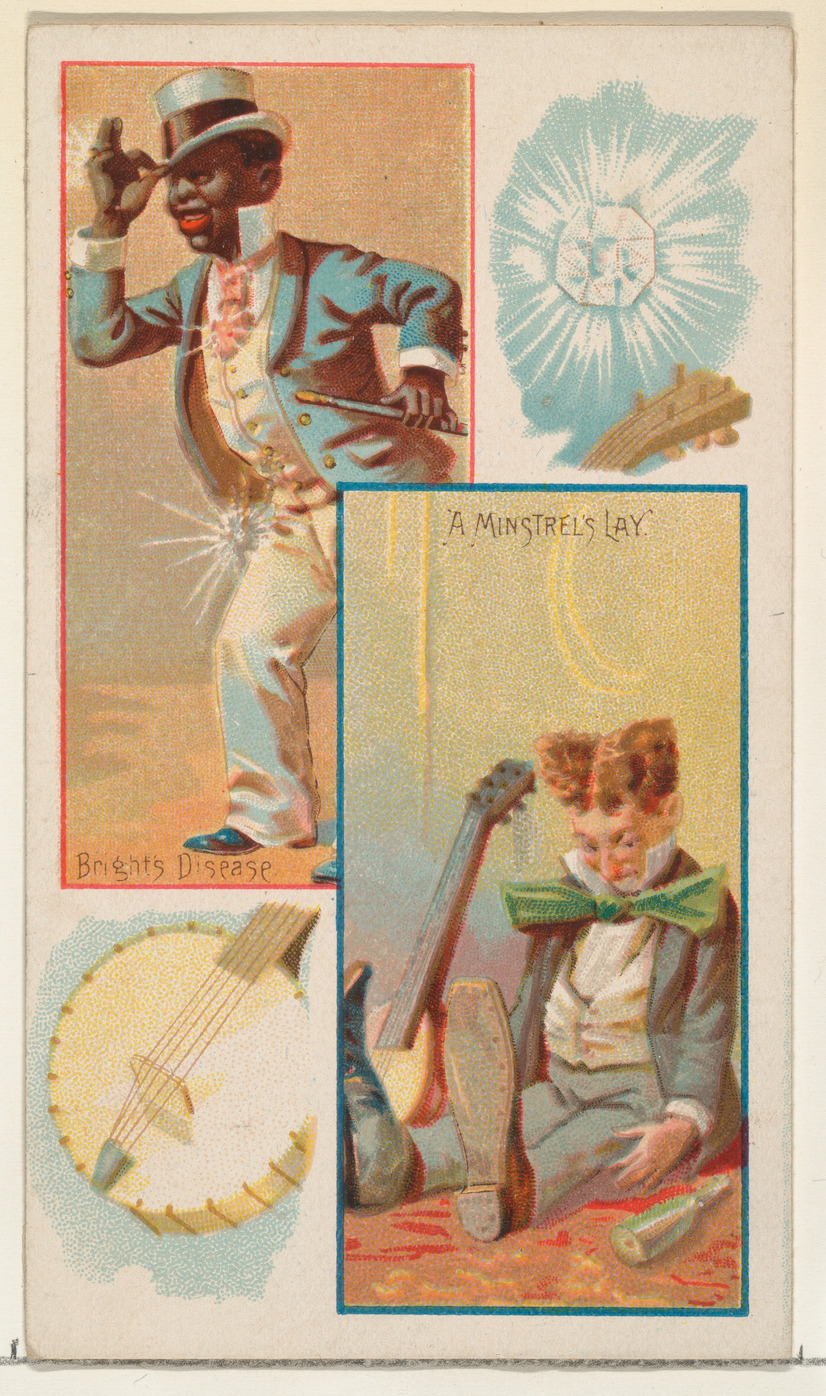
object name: print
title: Caricatured figures / Bright's Disease / A Minstrel's Lay, from the Jokes series (N118) issued by Duke Sons & Co. to promote Honest Long Cut Tobacco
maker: w. duke, sons & co.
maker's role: publisher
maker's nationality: american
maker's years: 1870-1920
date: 1891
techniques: color lithograph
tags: musical instruments,men